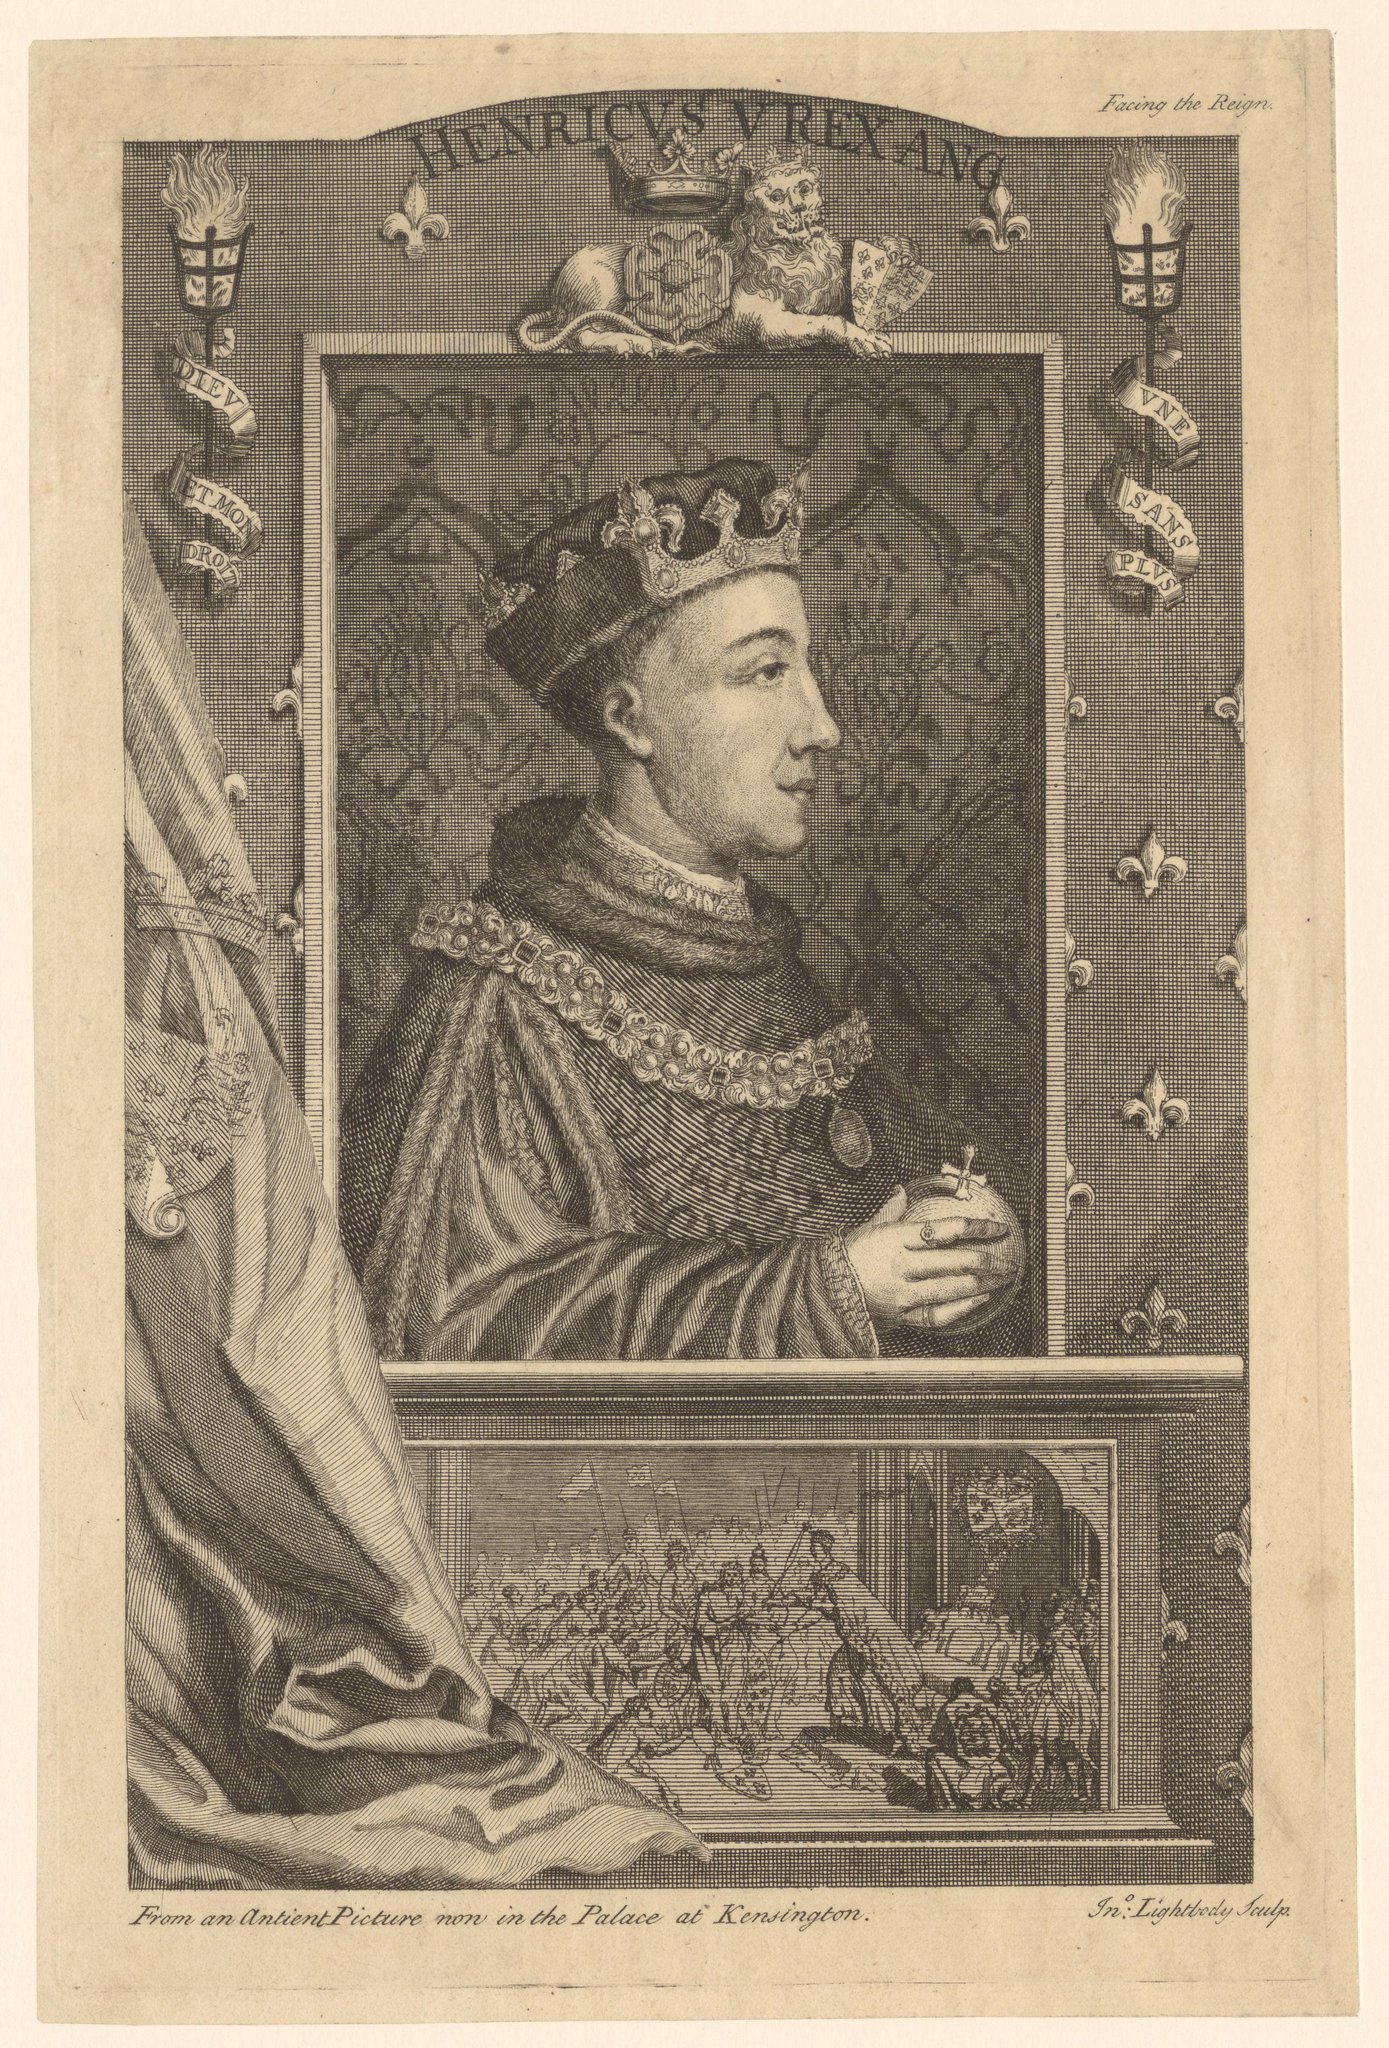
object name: print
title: Portret van Hendrik V, koning van Engeland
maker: inigo lightbody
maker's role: print maker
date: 1700-1800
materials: paper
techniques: engraving, etching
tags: historical persons, king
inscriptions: collector's mark: Lugt 2228